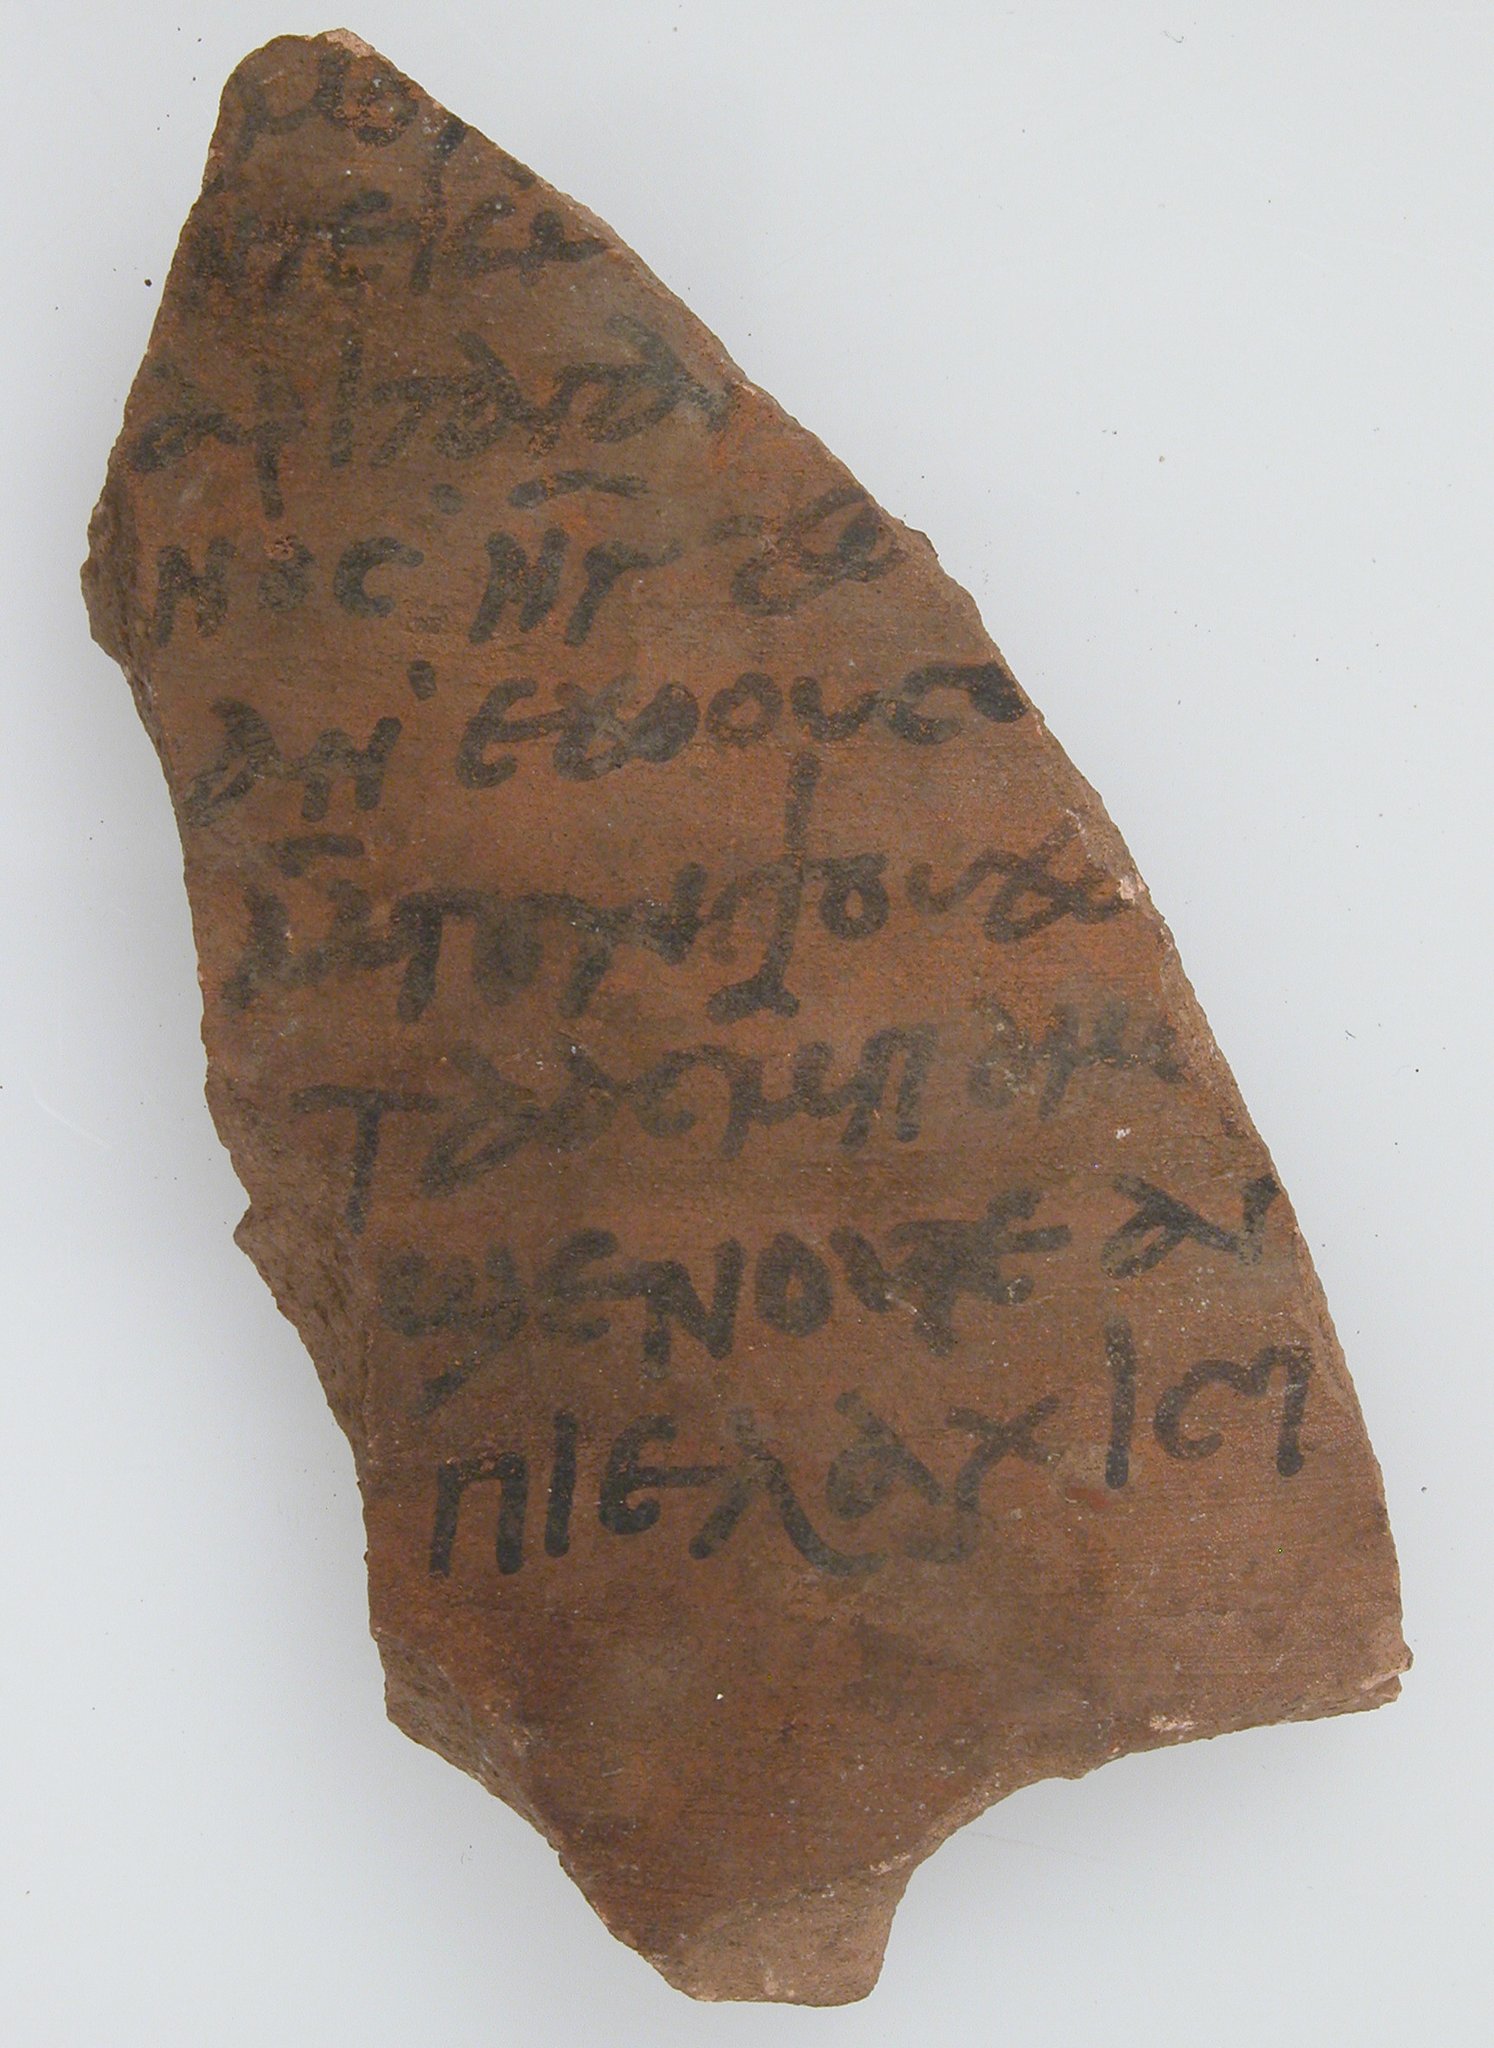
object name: ostrakon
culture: coptic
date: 601-700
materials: ink, pottery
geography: egypt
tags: coptic